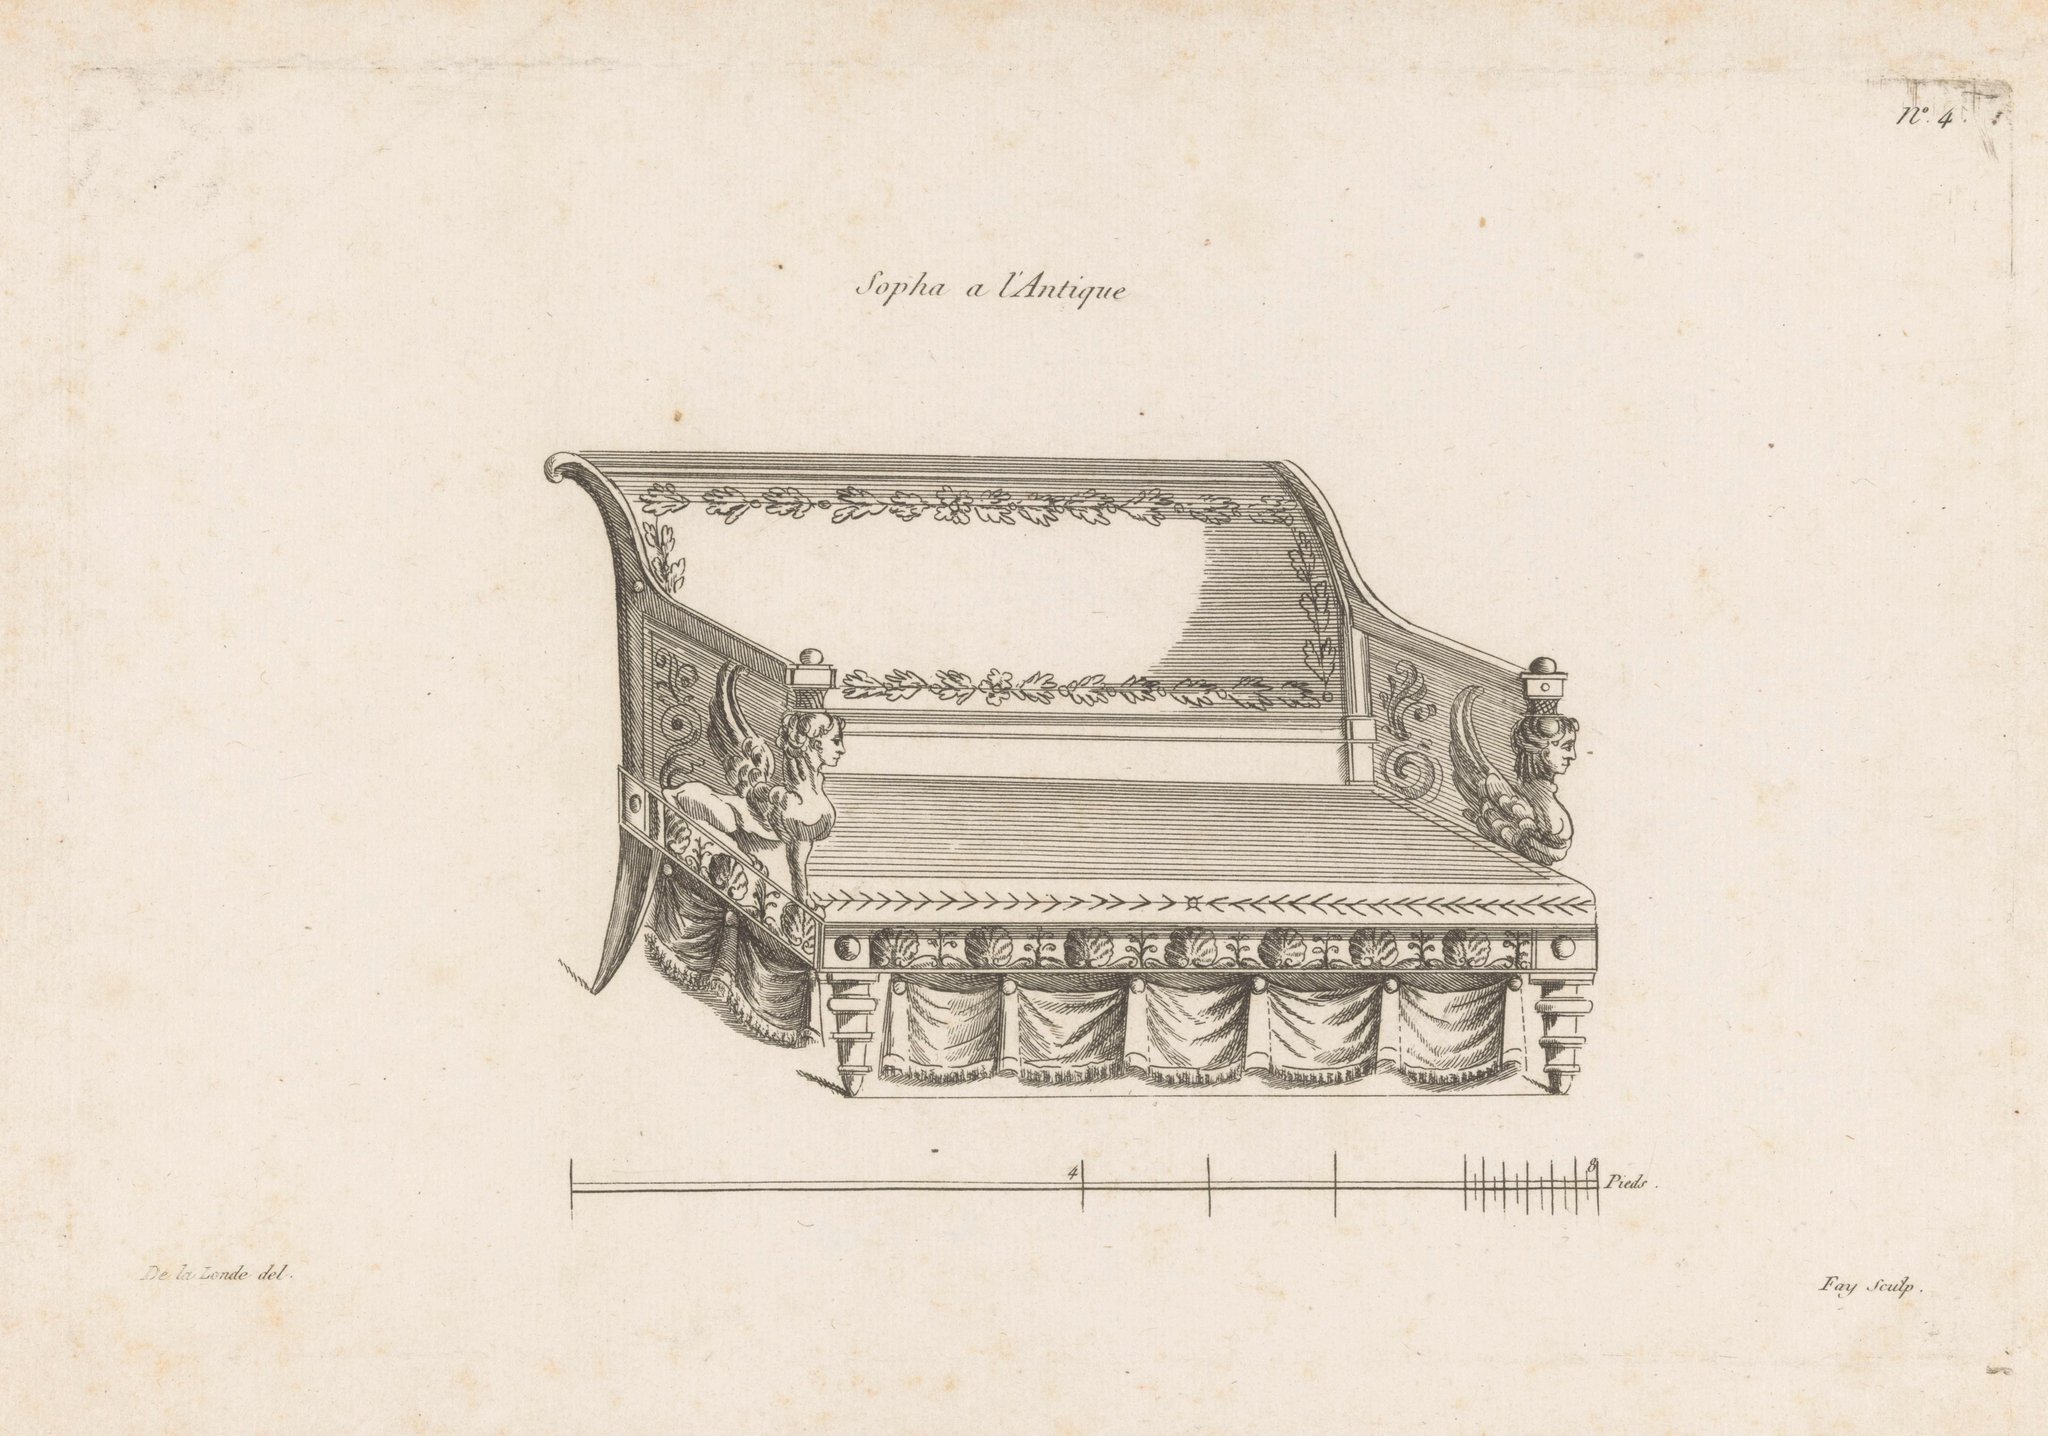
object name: ornament print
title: Sopha a l'Antique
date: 1784-1796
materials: paper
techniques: etching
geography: paris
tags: couch, sofa, settee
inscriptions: collector's mark: Lugt 2760, collector's mark: Lugt 2228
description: Een geornamenteerde sofa met blad- en schelpmotieven, draperieën en twee sfinxen.